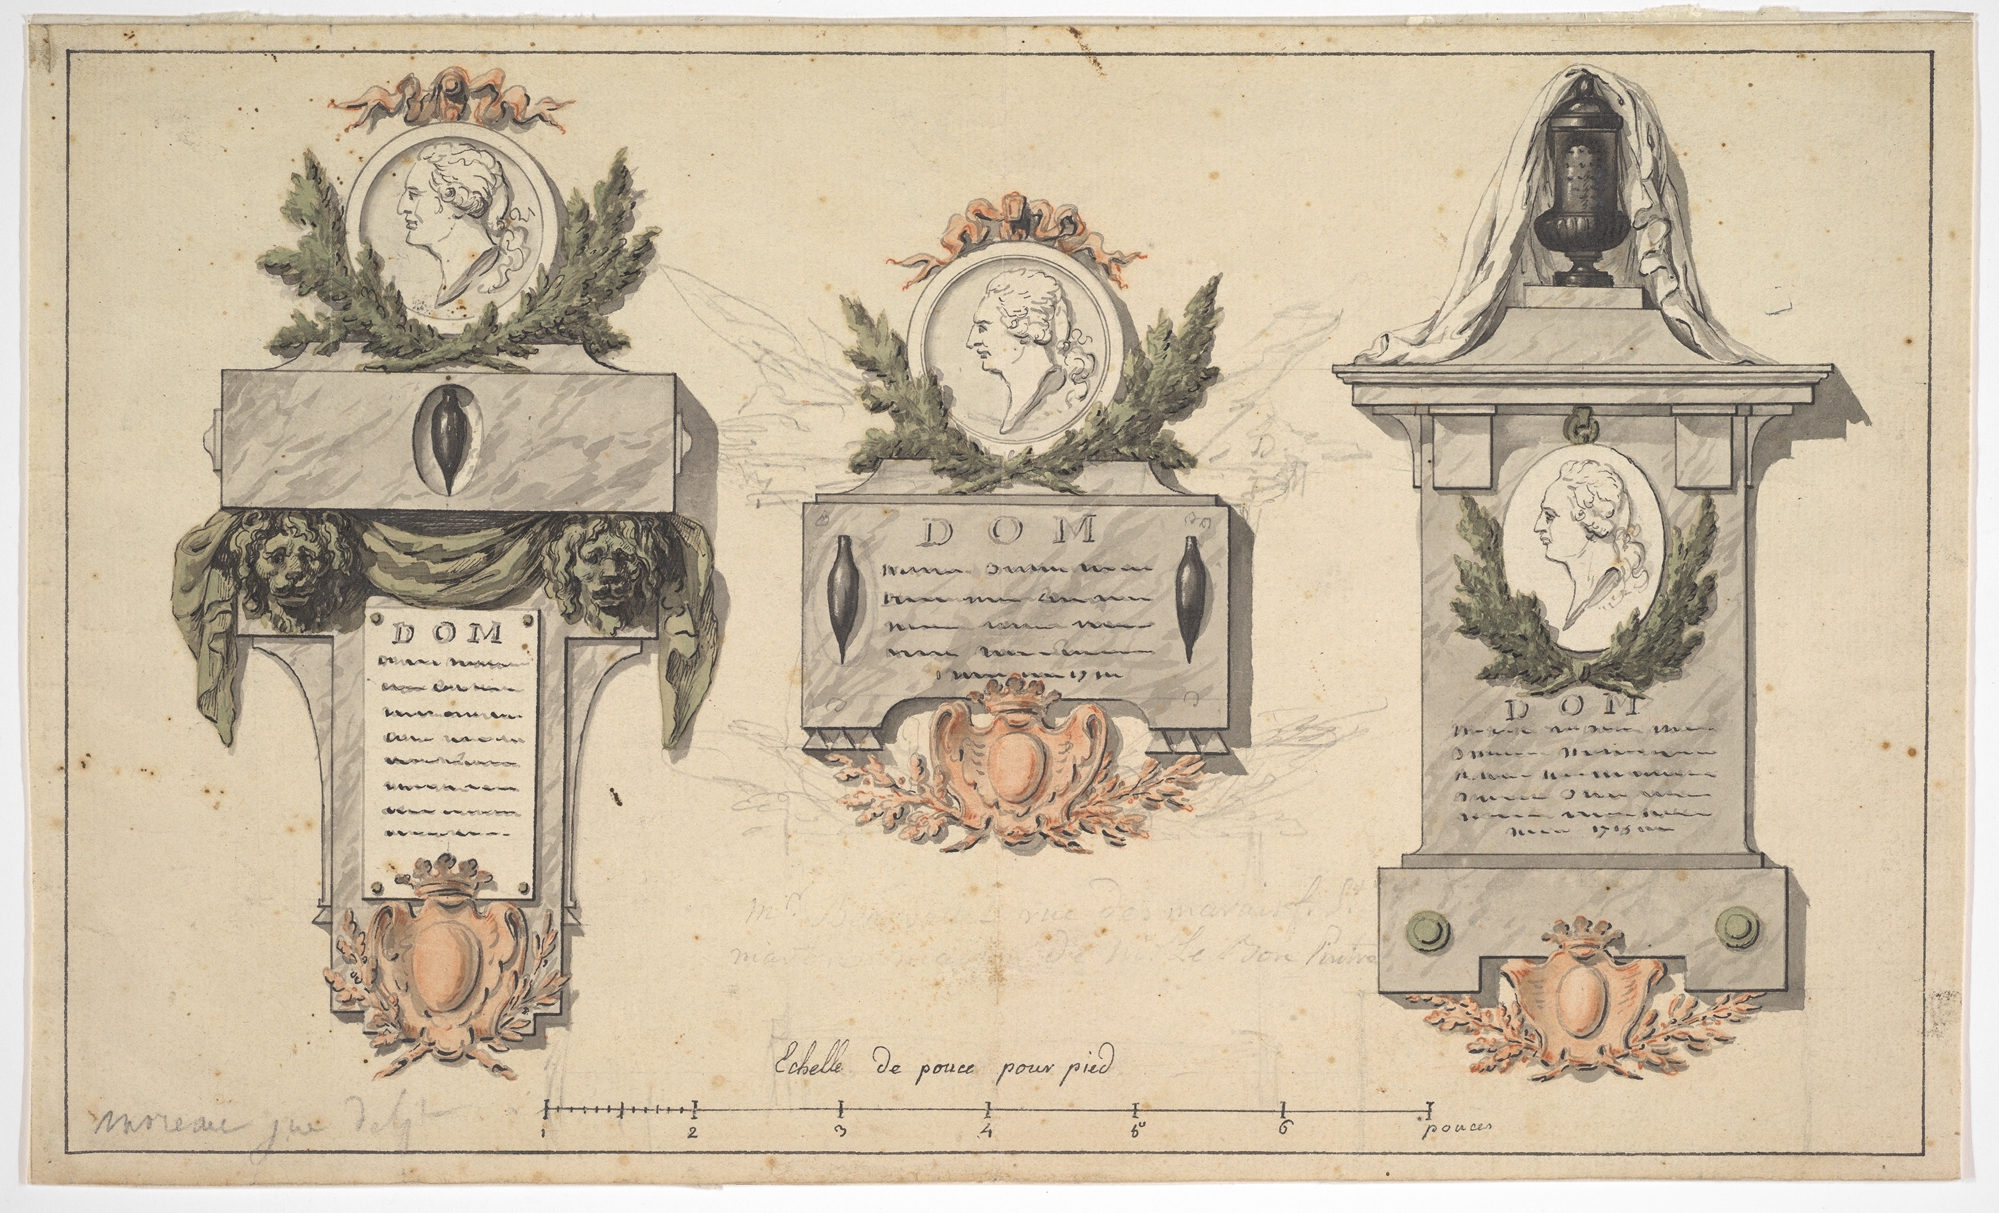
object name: ornament architecture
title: Three Designs for a Funerary Monument or Epitaph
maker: jean michel moreau le jeune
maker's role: artist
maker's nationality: french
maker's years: 1741-1814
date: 1770-1790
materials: graphite, ink, watercolor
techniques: pen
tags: monuments,men,profiles,insignia